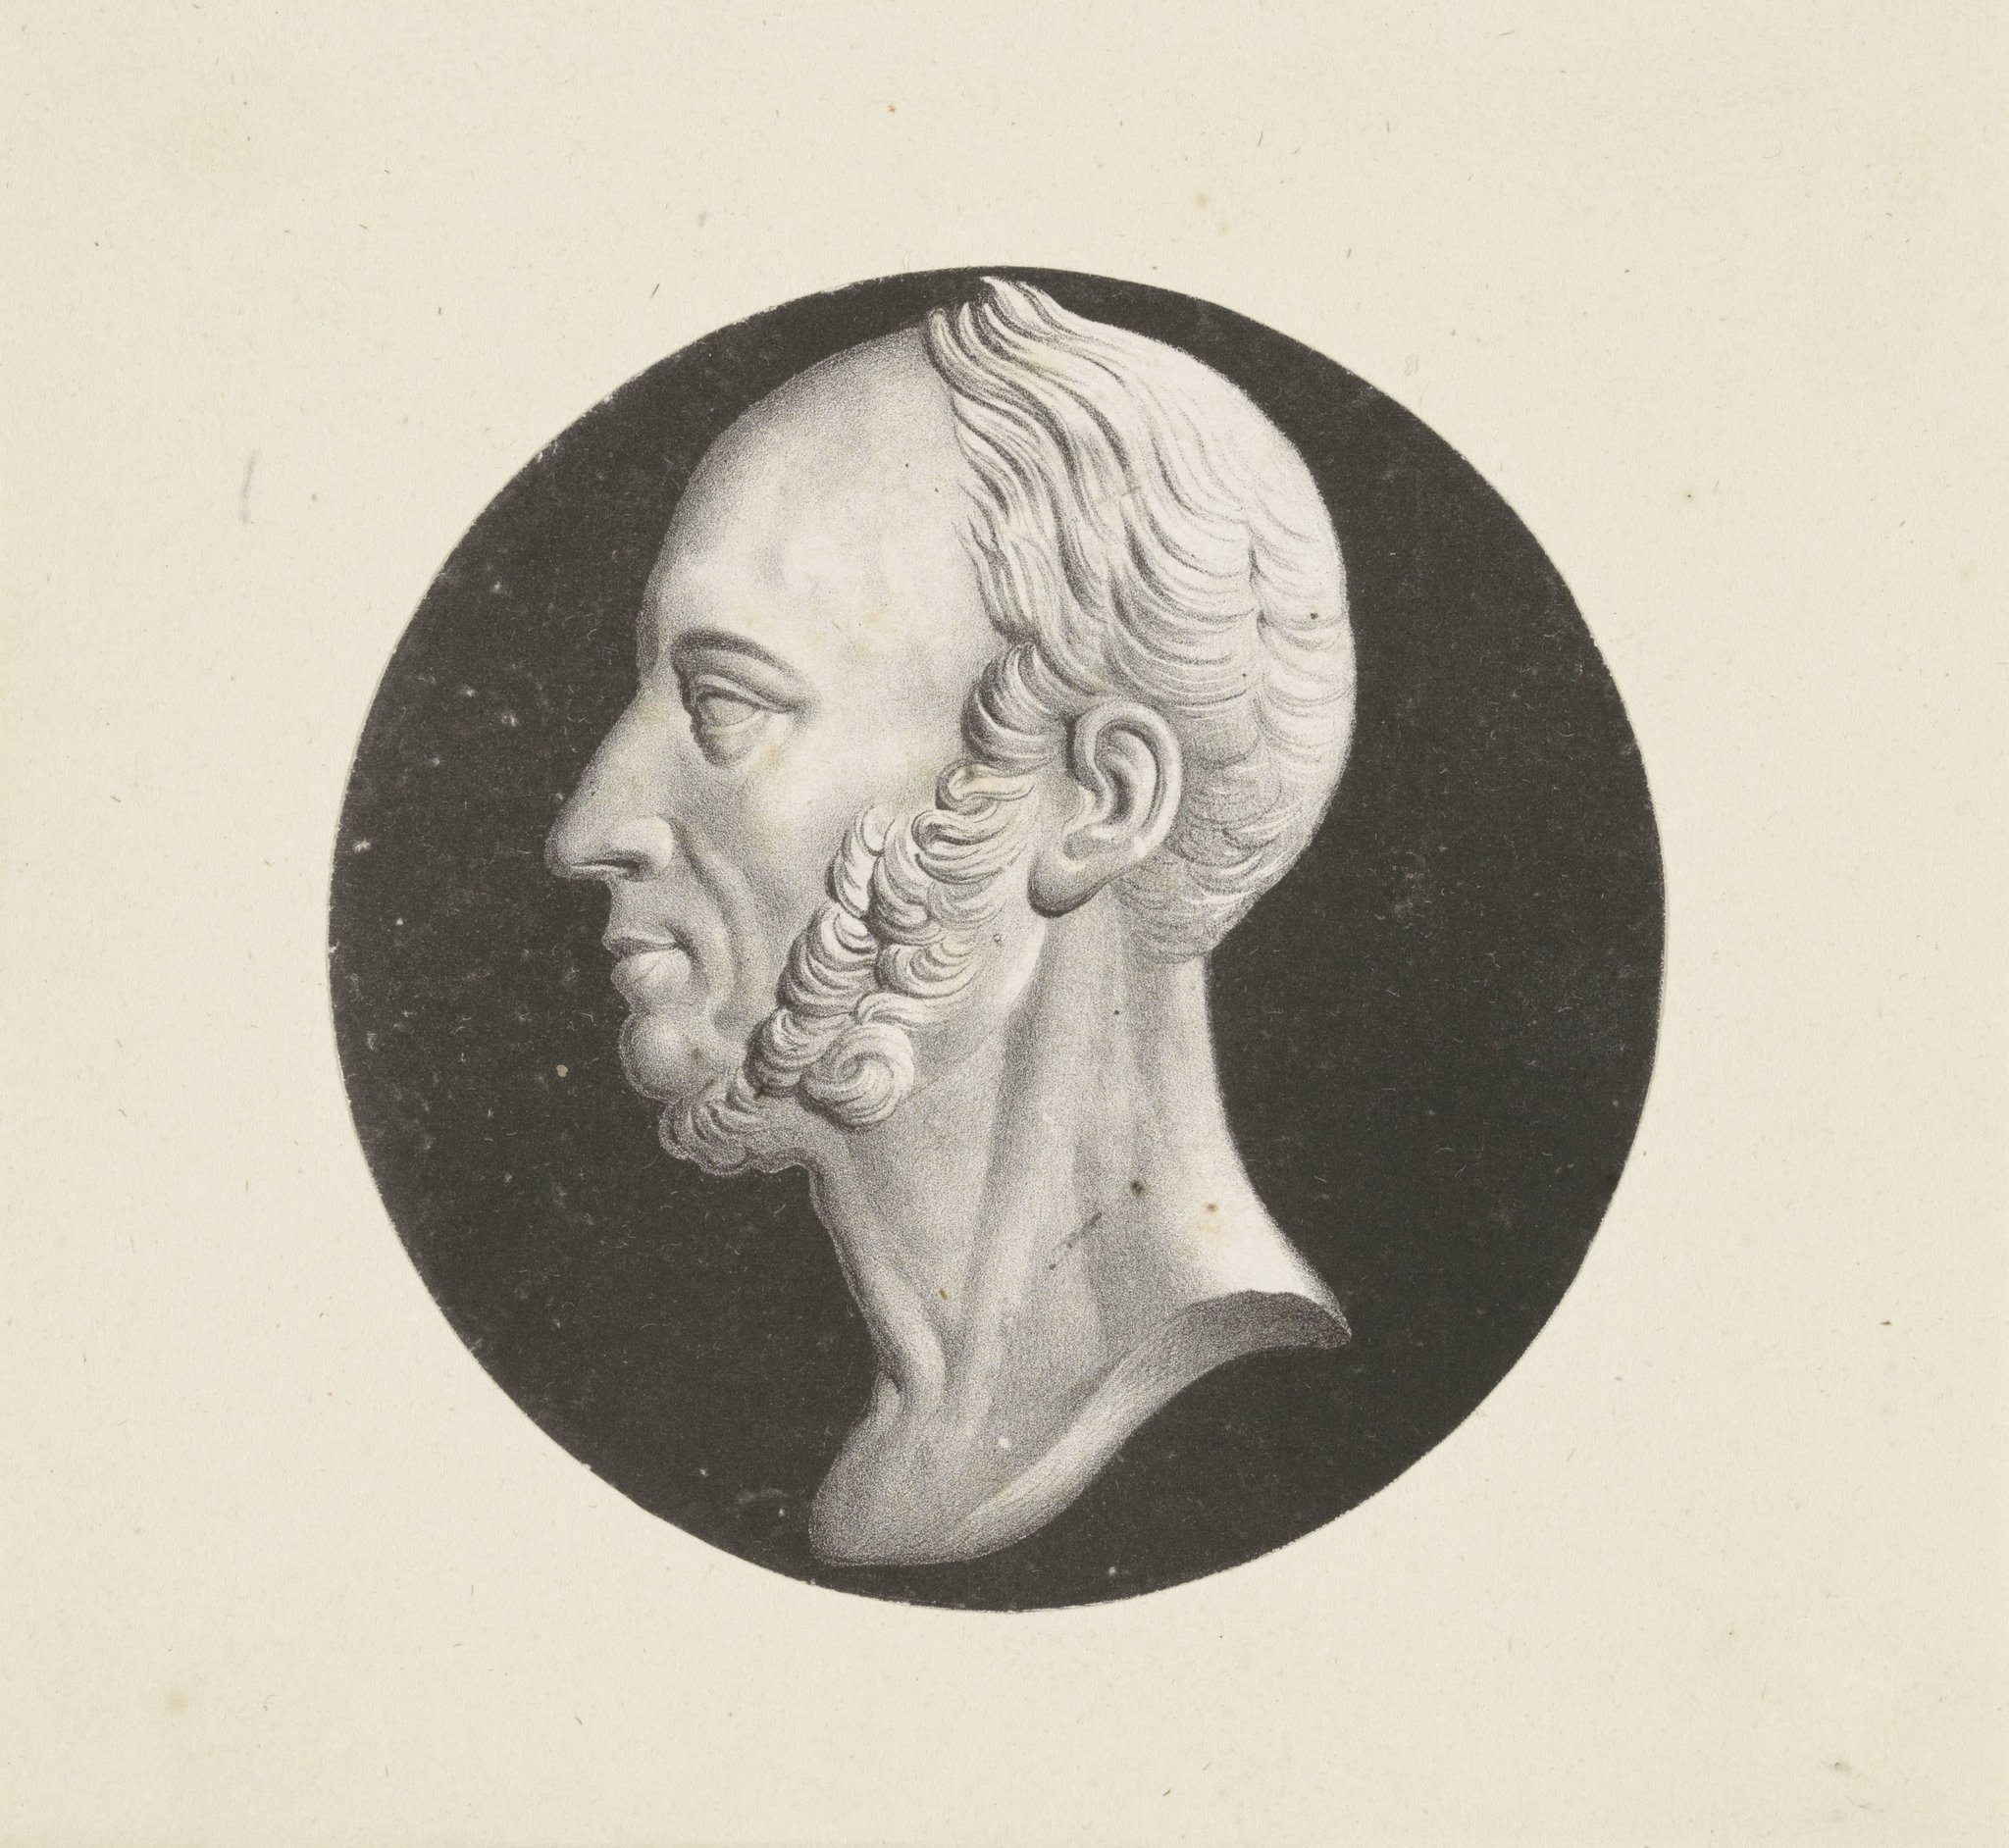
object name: print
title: Buste van Willem II, koning der Nederlanden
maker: Anonymous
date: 1840-1899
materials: paper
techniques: lithograph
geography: netherlands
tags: william ii of the netherlands, piece of sculpture, reproduction of a piece of sculpture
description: De hier vermelde titel verwijst naar de hoogst verkregen titel van de geportretteerde, niet per se naar de titel die de geportretteerde op deze voorstelling draagt.